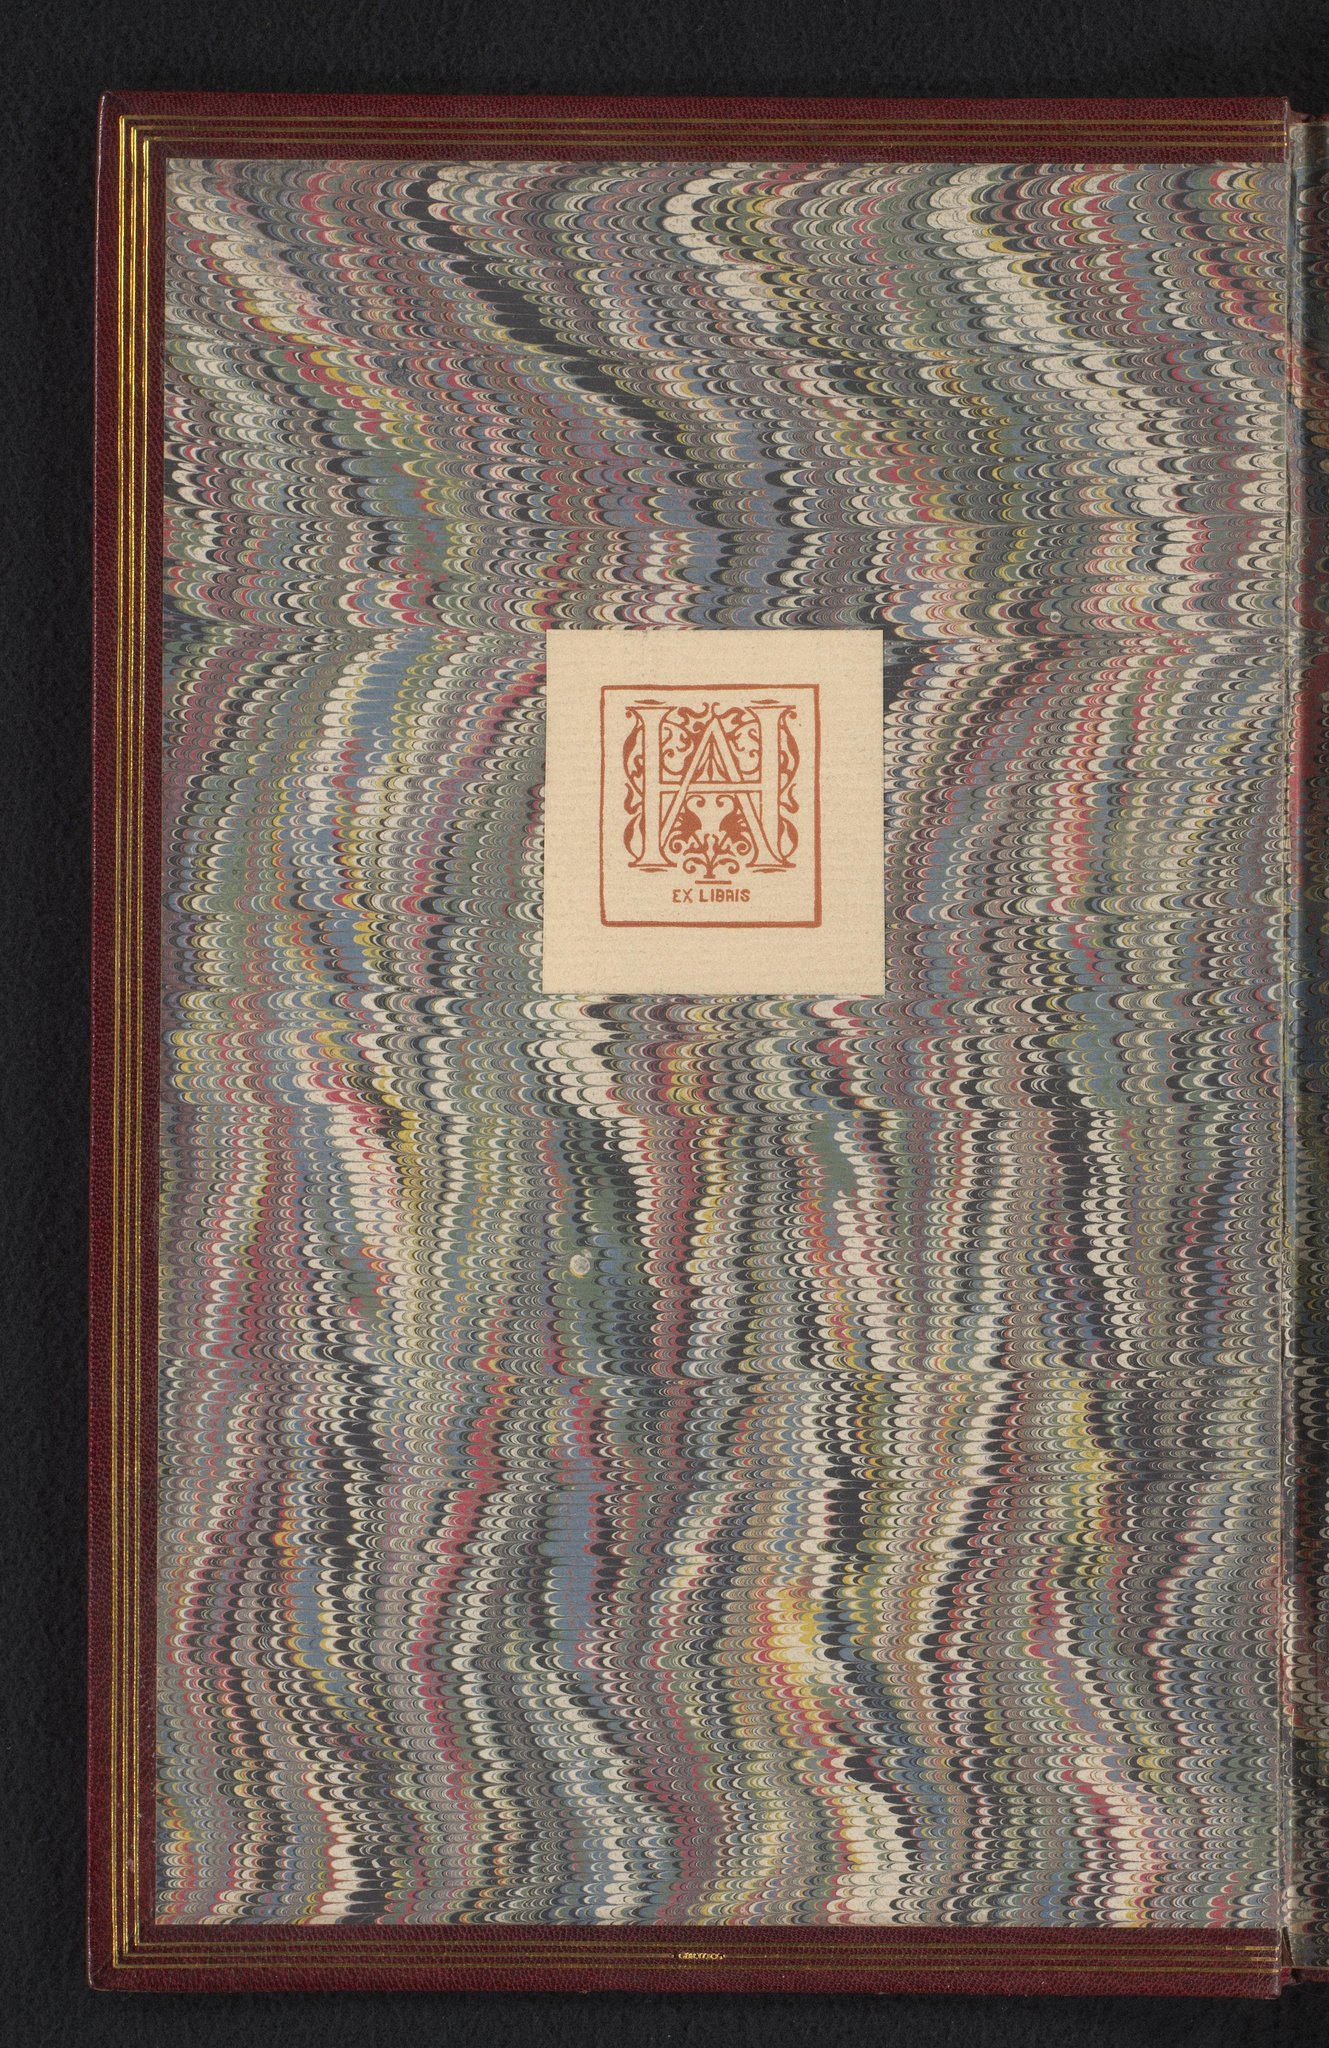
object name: bookplate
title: Schutblad met typografisch ex libris van André-Jean Hachette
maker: Anonymous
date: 1900-1952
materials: paper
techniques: woodcut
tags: ex-libris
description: Ex libris in: Colonna, Francesco. Hypnerotomachie ou discours du songe de Poliphile, deduisant comme amour le combat a l'occasion de Polia. Parijs: Jacques Kerver, 1546.